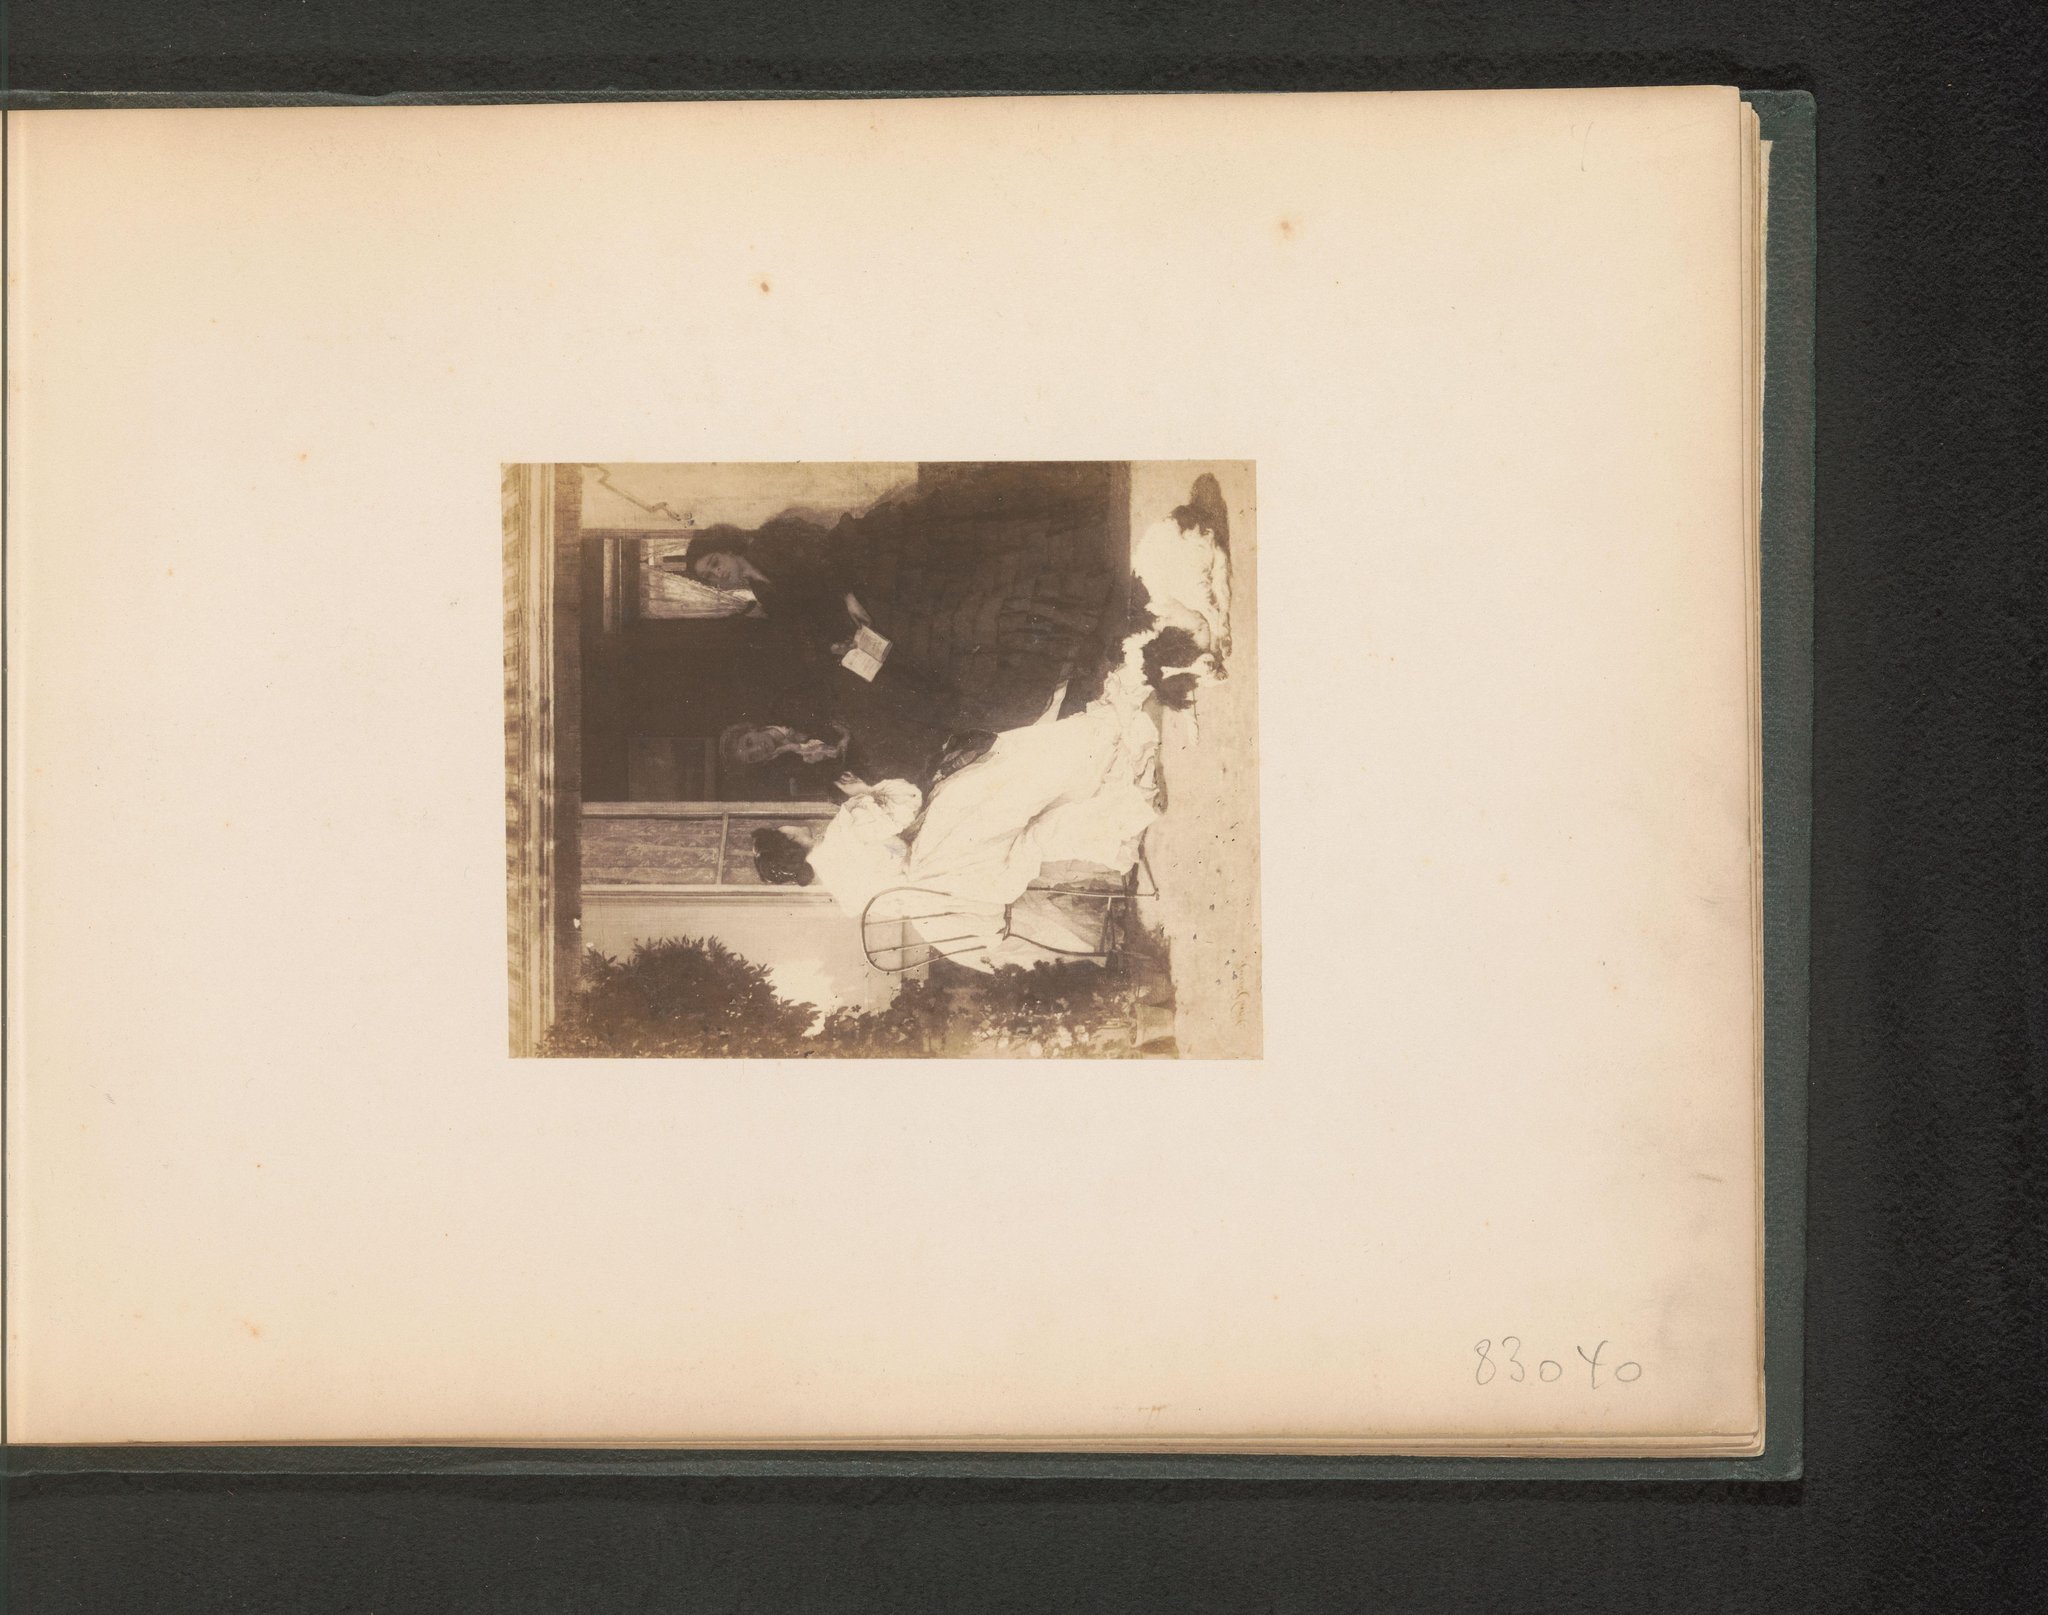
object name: reproduction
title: Fotoreproductie van Coversation au jardin van Alfred Stevens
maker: Anonymous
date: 1858-1863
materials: photographic support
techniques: albumen print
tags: adult woman, open window, picture, painting